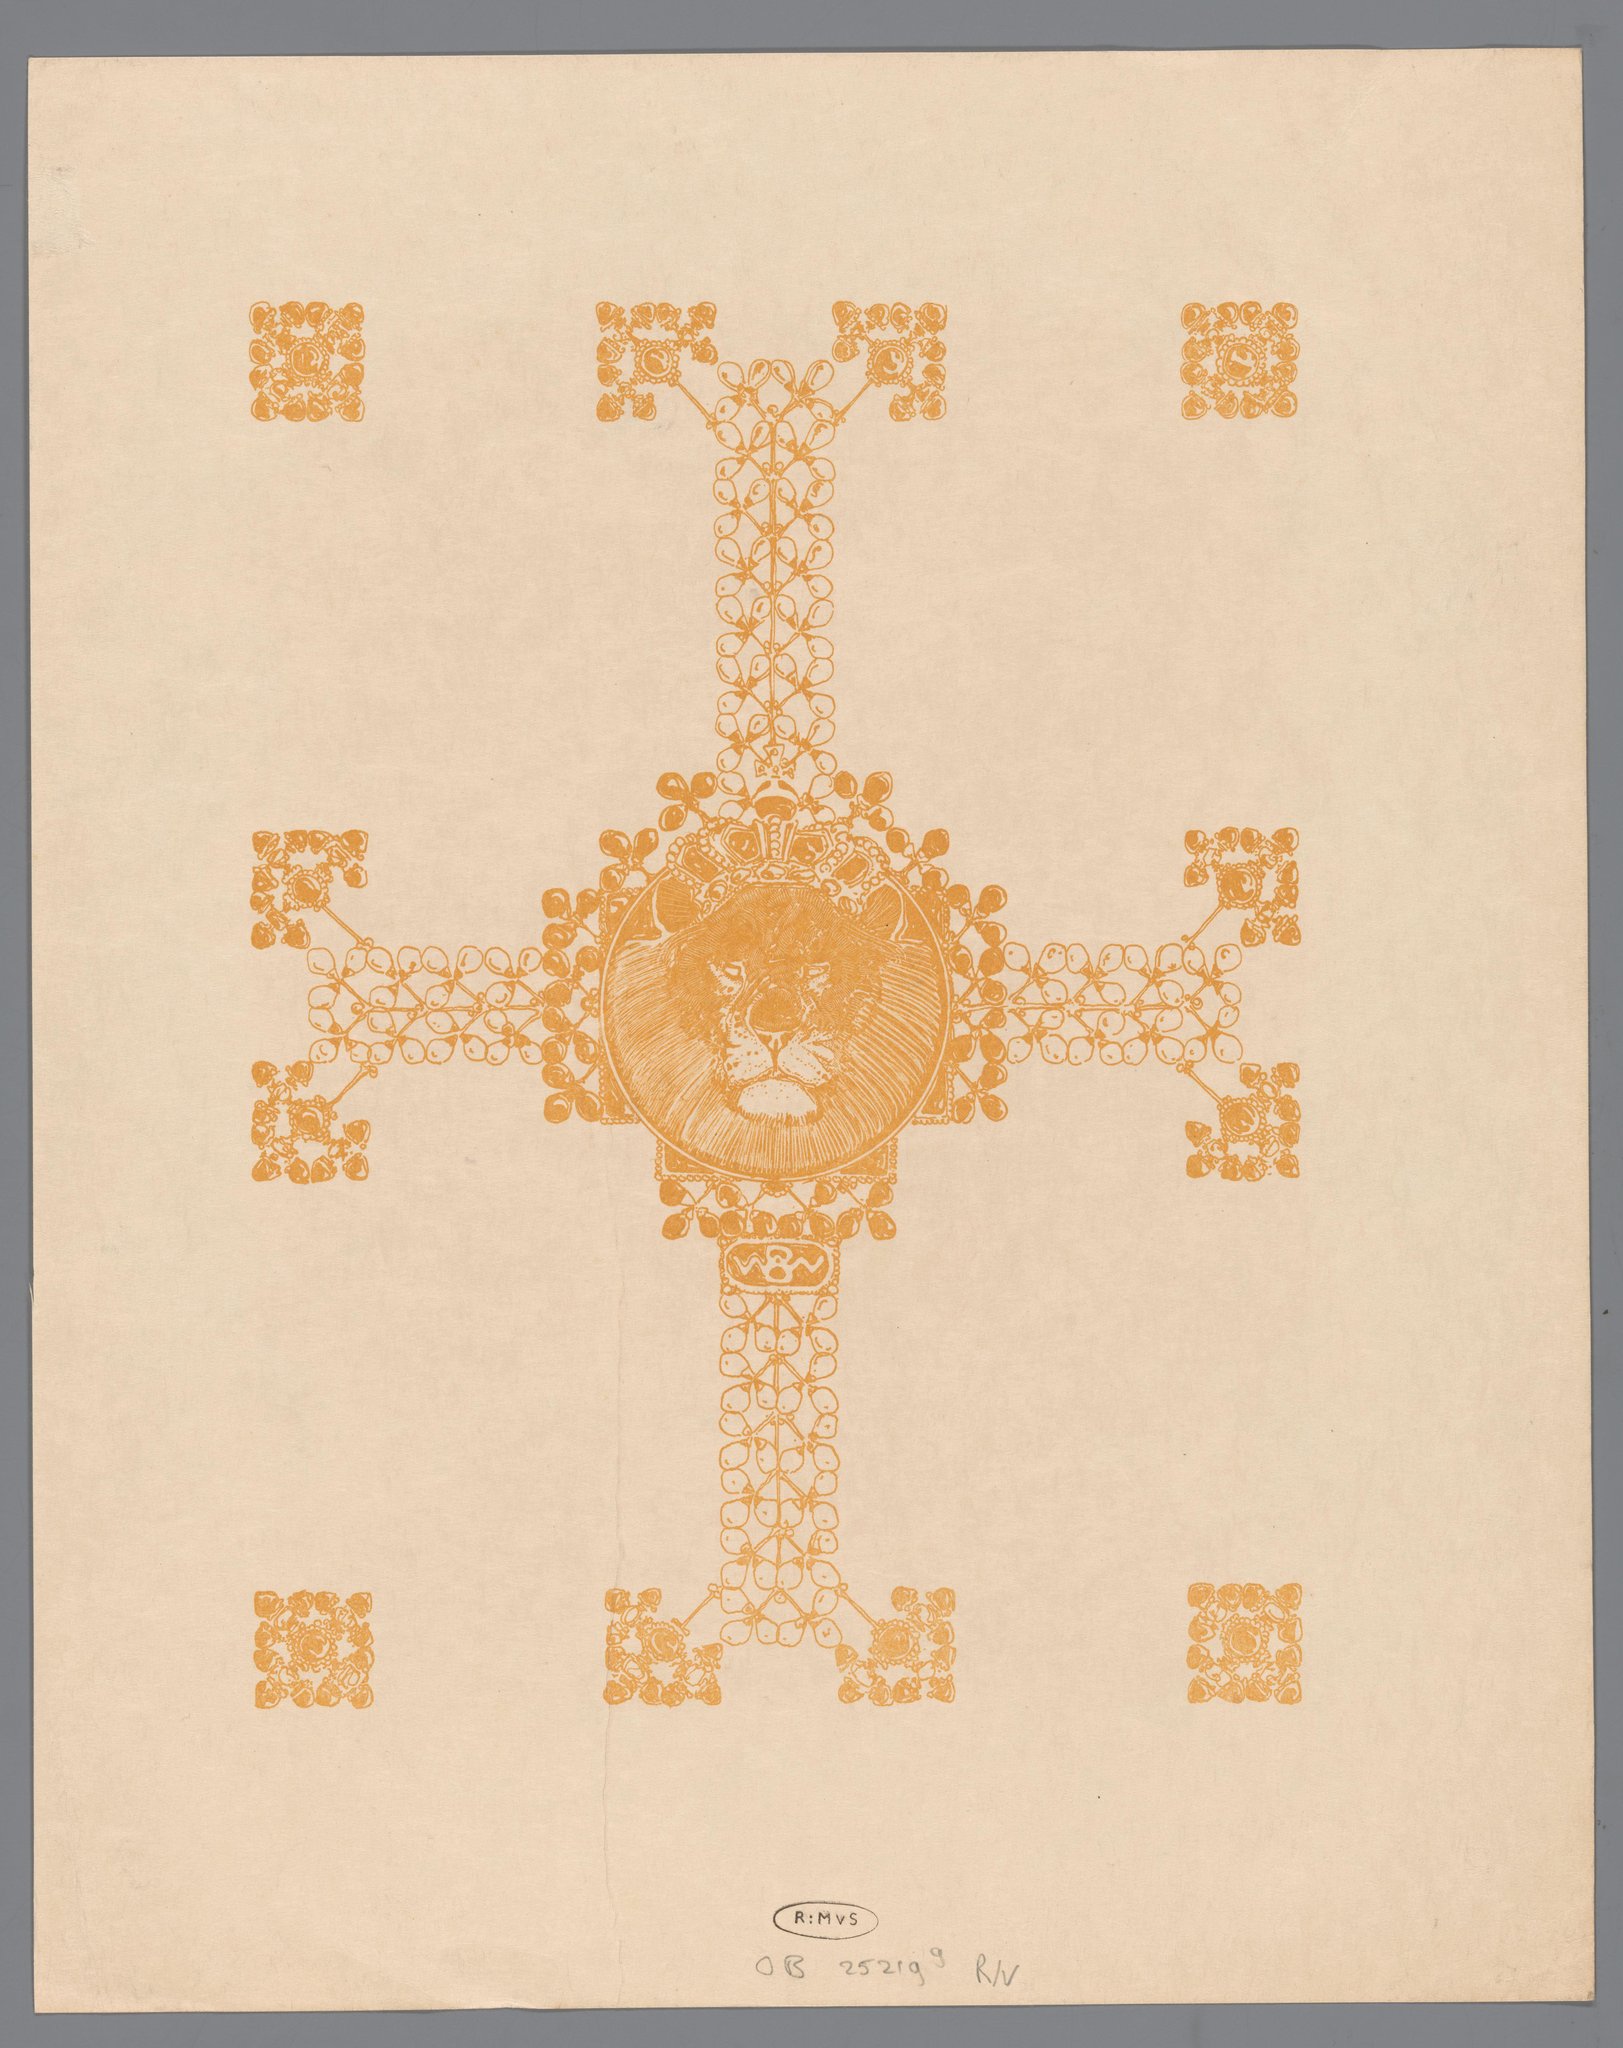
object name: book illustration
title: Ornamentiek en gekroonde leeuw (Nobel)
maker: bernard willem wierink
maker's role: draughtsman, print maker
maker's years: 1856-1939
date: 1910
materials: paper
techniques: lithograph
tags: fable of reynard the fox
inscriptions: collector's mark: Lugt 2228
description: Prent gebruikt in: Streuvels, Stijn (Frank Lateur). Reinaert de Vos naar verschillende uitgaven van het middeleeuwsche epos. Amsterdam: L.J. Veen, 1910.